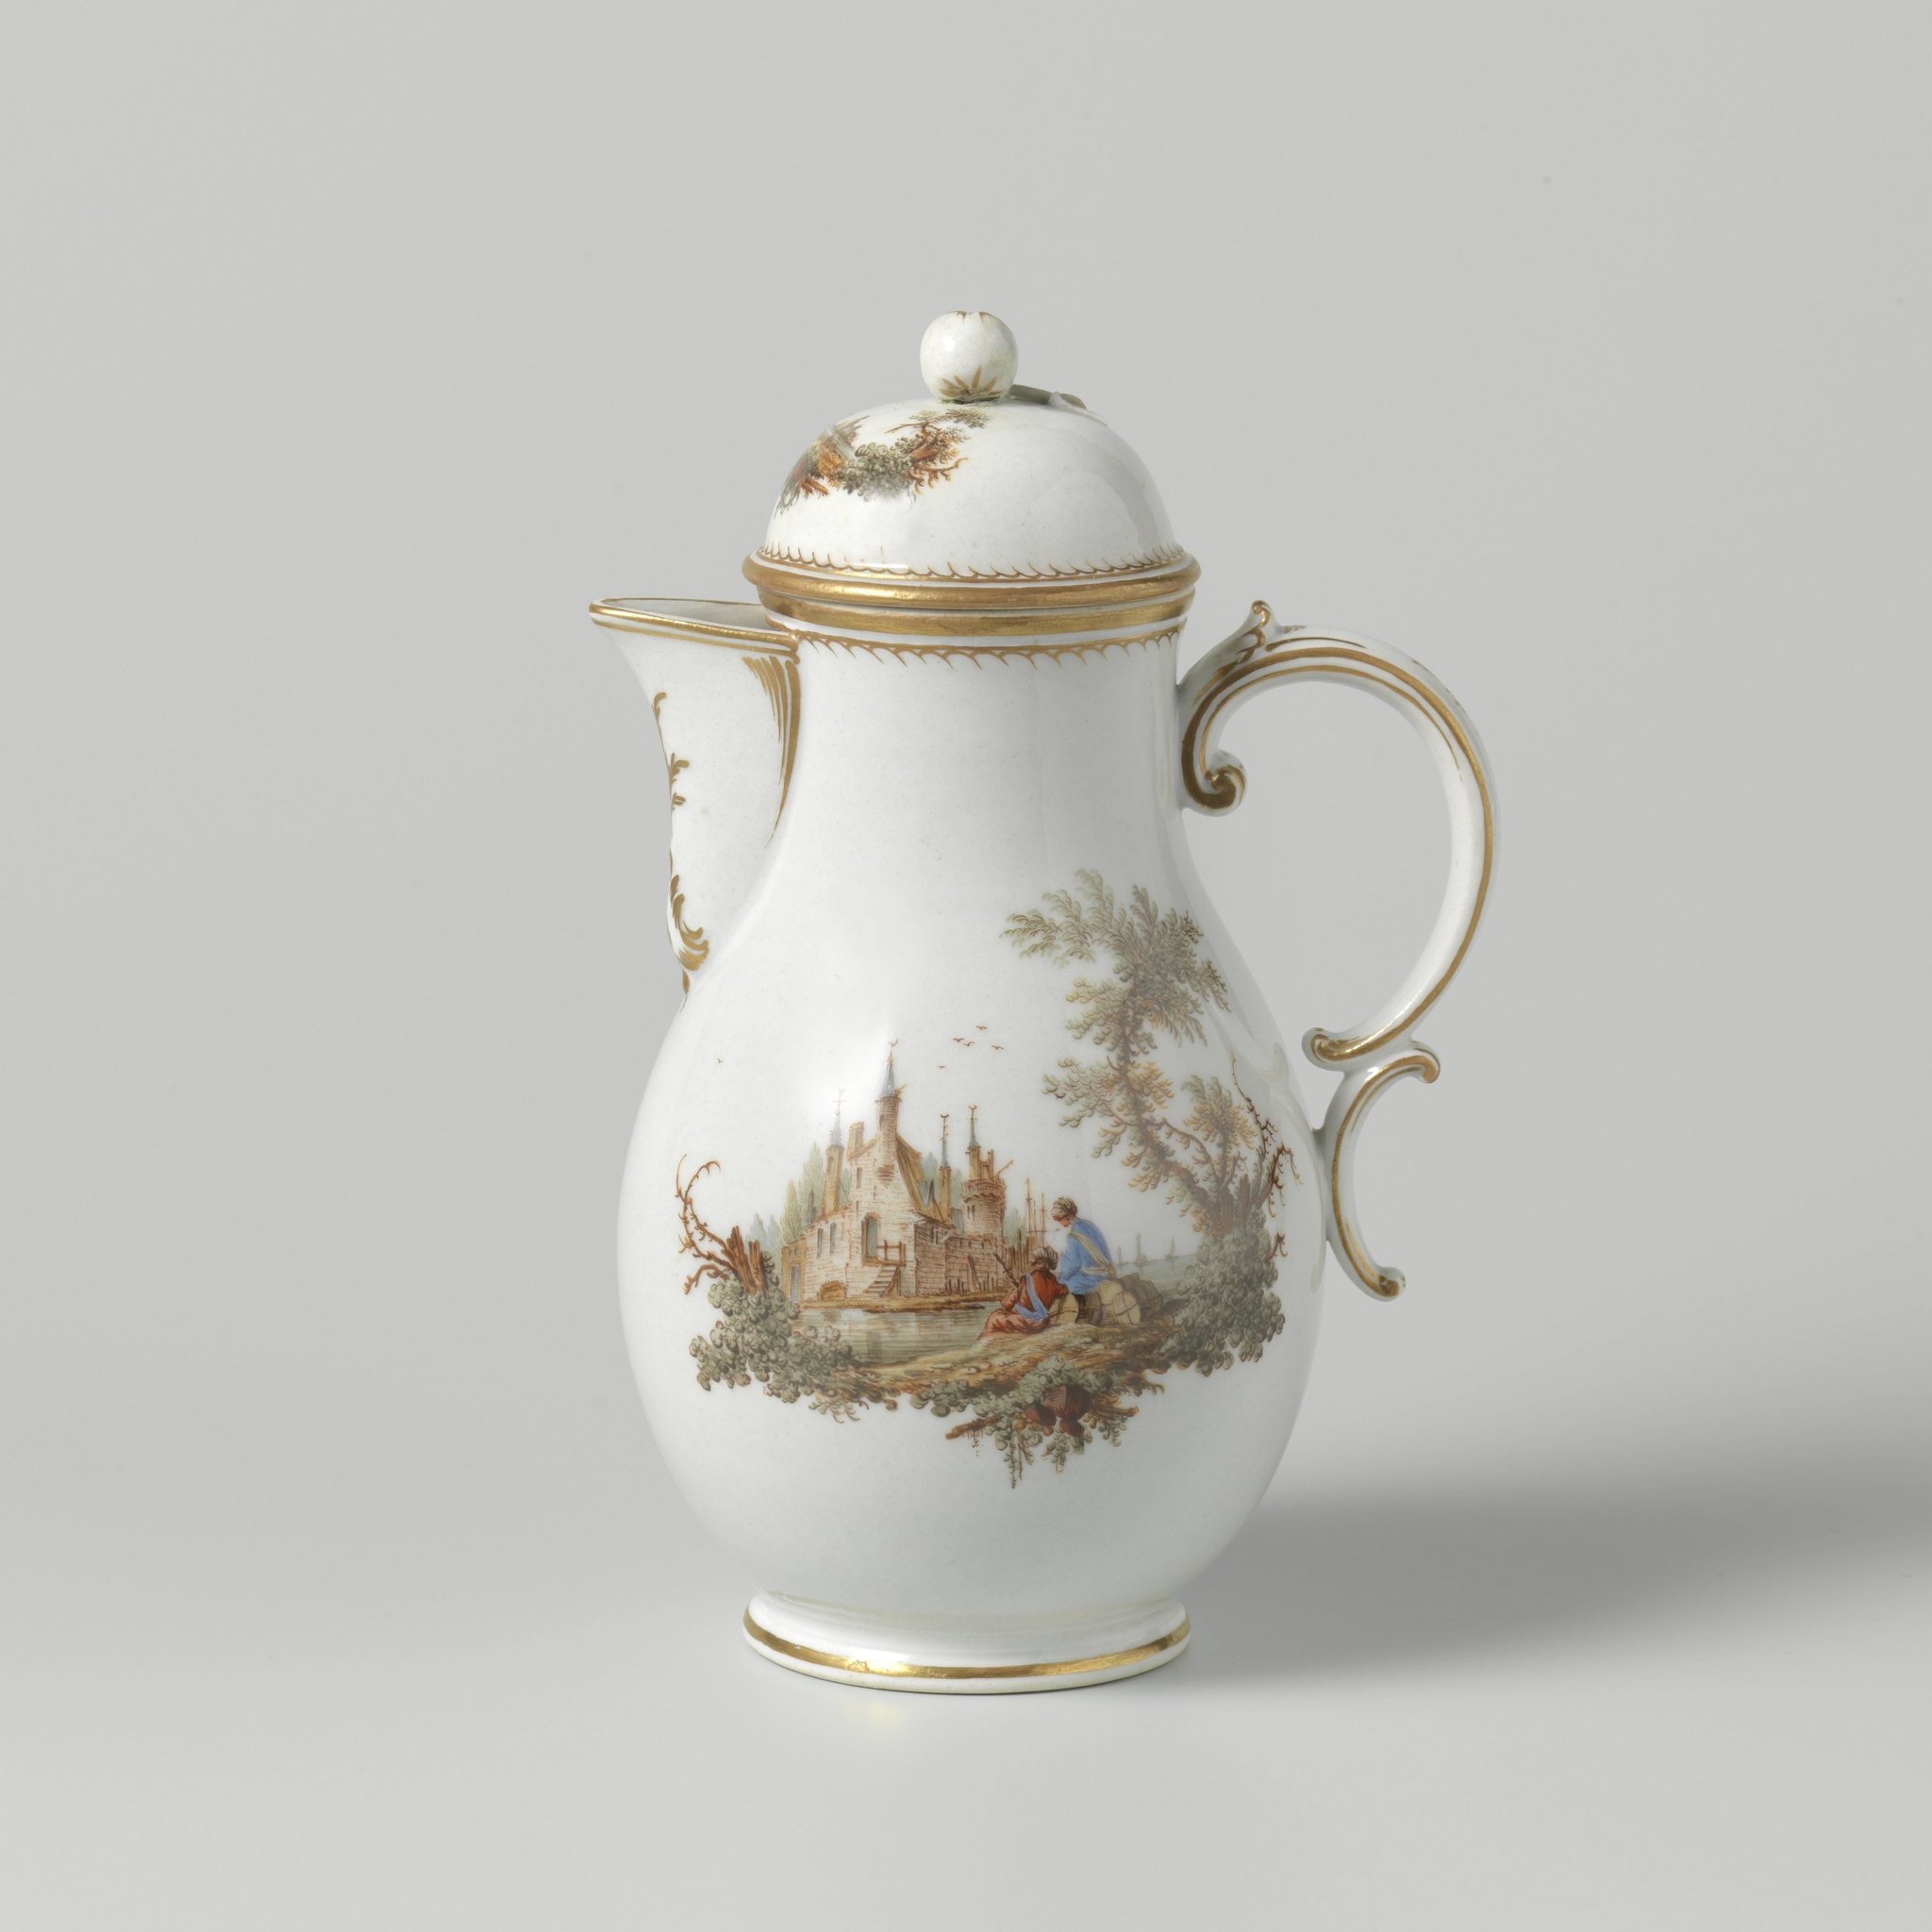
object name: milk jug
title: Part of a coffee and tea service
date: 1778-1782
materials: porcelain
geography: loosdrecht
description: Manufactuur Oud-Loosdrecht Loosdrecht, c. 1778–1782 hard-paste porcelain